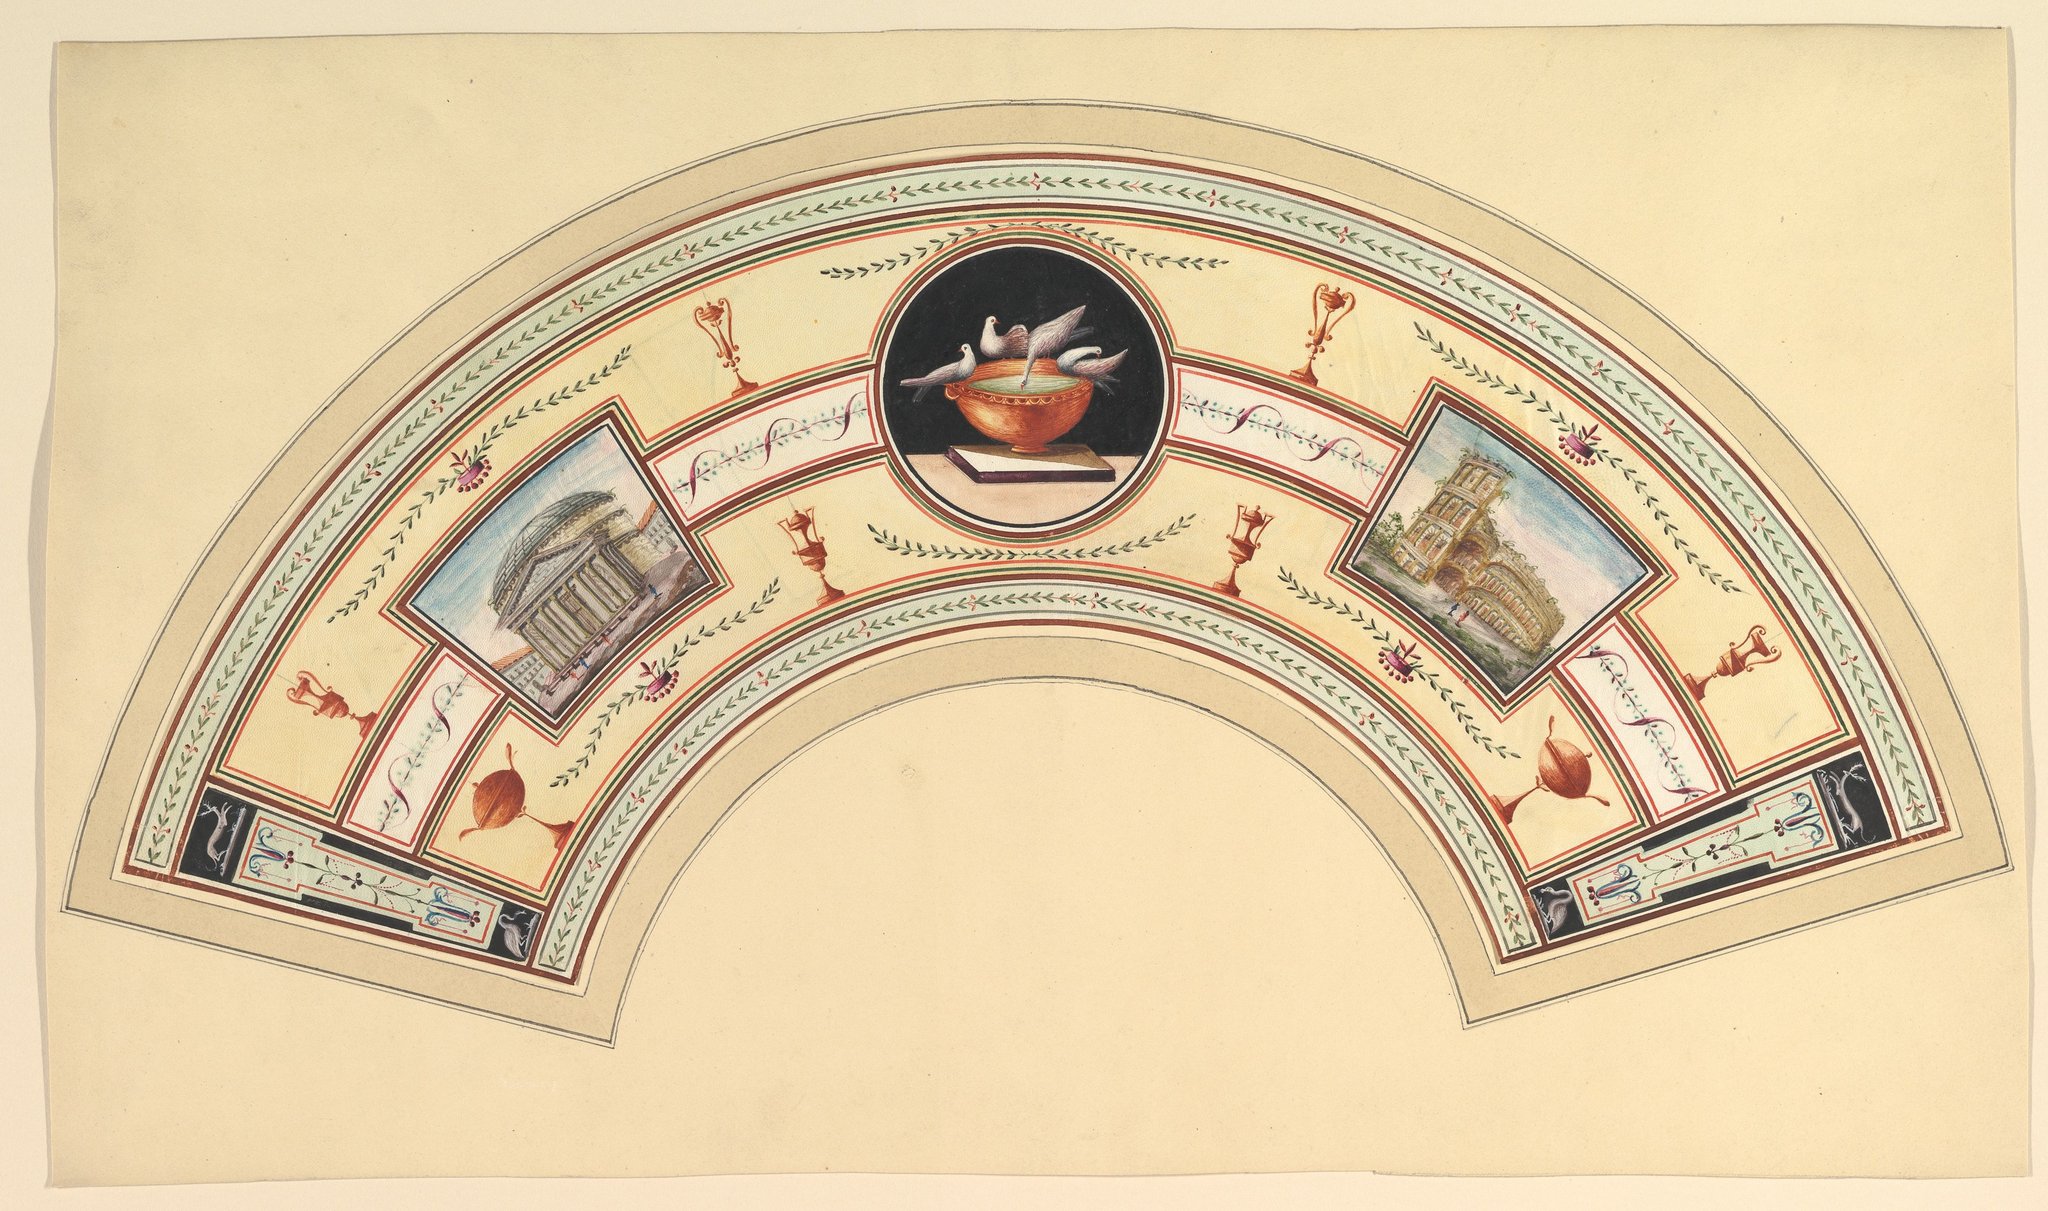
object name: drawing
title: Fan Design with the Pantheon and the Colosseum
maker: anonymous, italian, 18th century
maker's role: artist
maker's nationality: italian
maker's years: 1700-1800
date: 1701-1800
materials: gouache, parchment, watercolor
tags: birds,buildings,fans